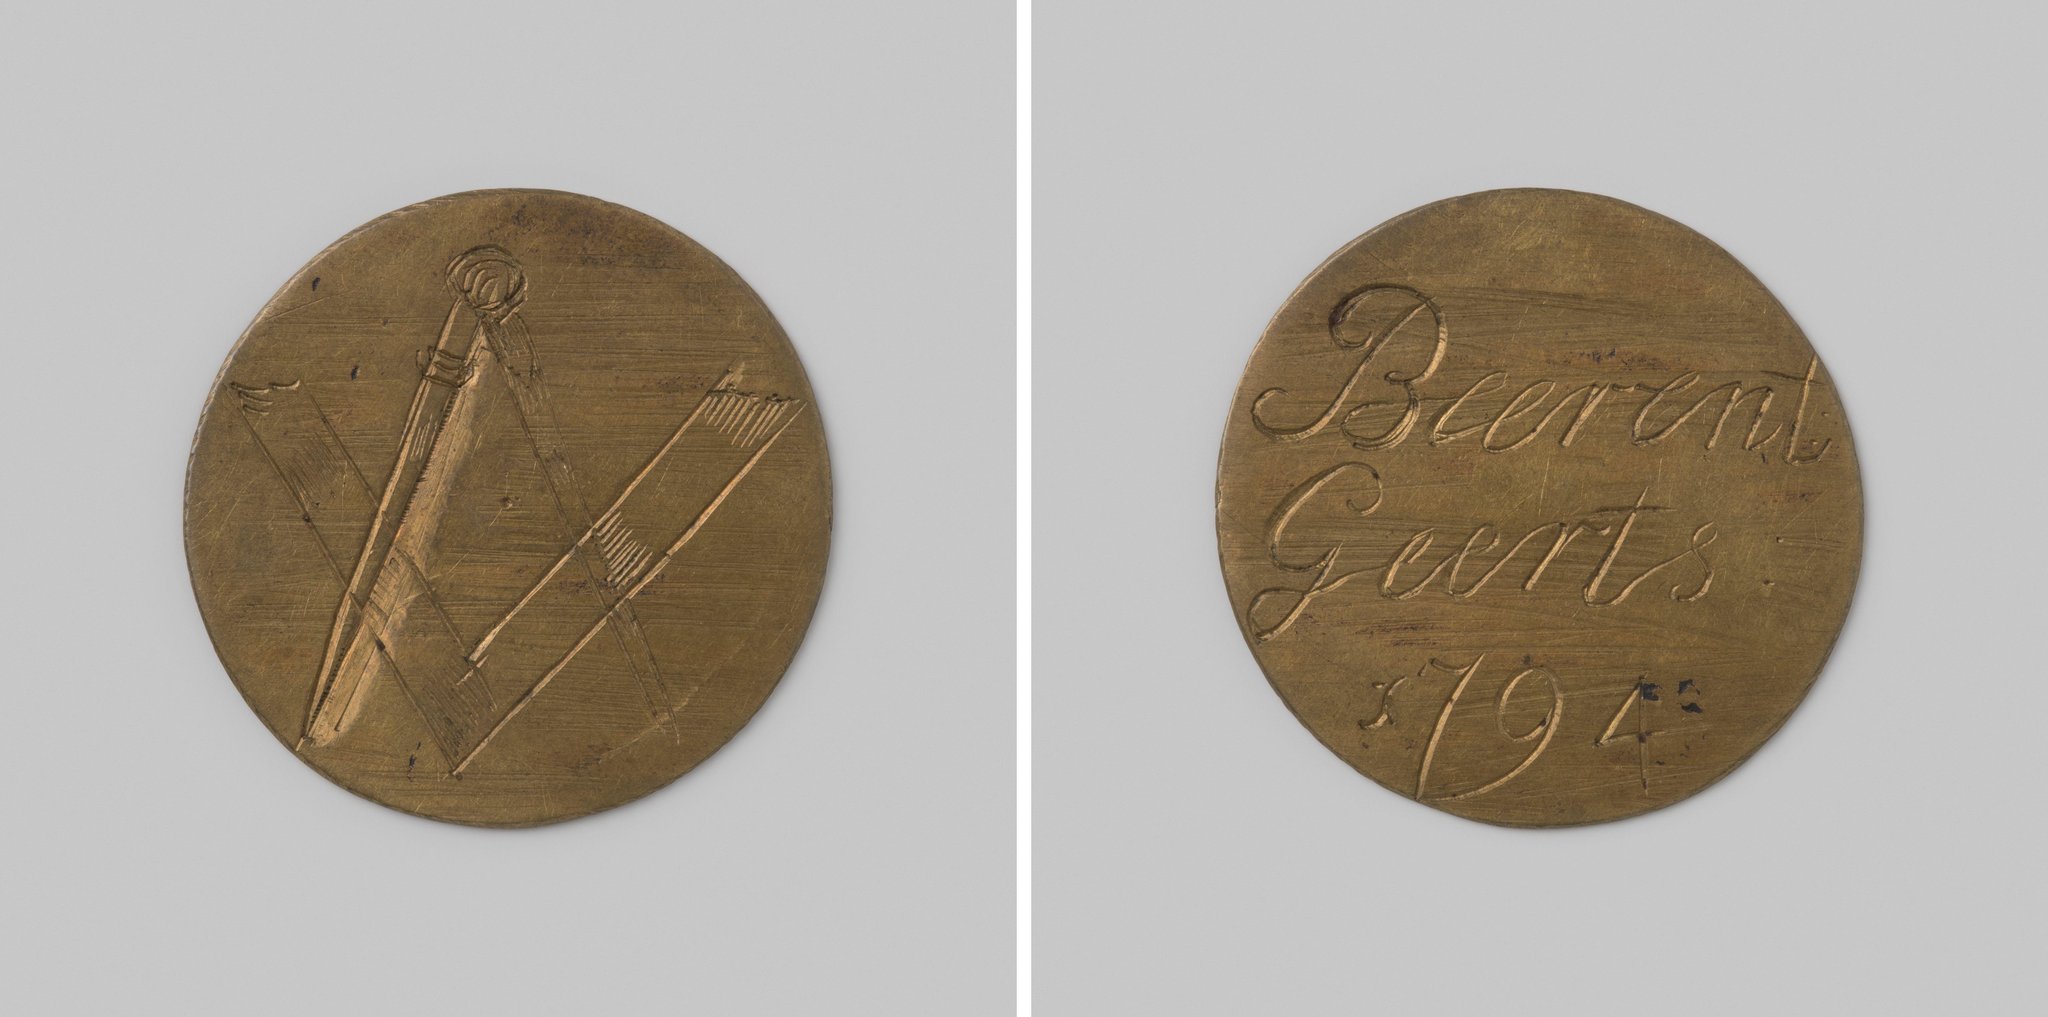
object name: medal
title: Presentiepenning van het Metselaars-, timmerlieden- en leidekkersgilde te Groningen, voor timmerlieden, 1768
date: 1768-1794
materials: brass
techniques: engraving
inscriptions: inscription: ‘Beerent / Geerts / 1794’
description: Rond messing plaatje gegraveerd op de voorzijde een passer en een winkelhaak, op de keerzijde drie regels tekst, op naam van Beerent Geerts 1794